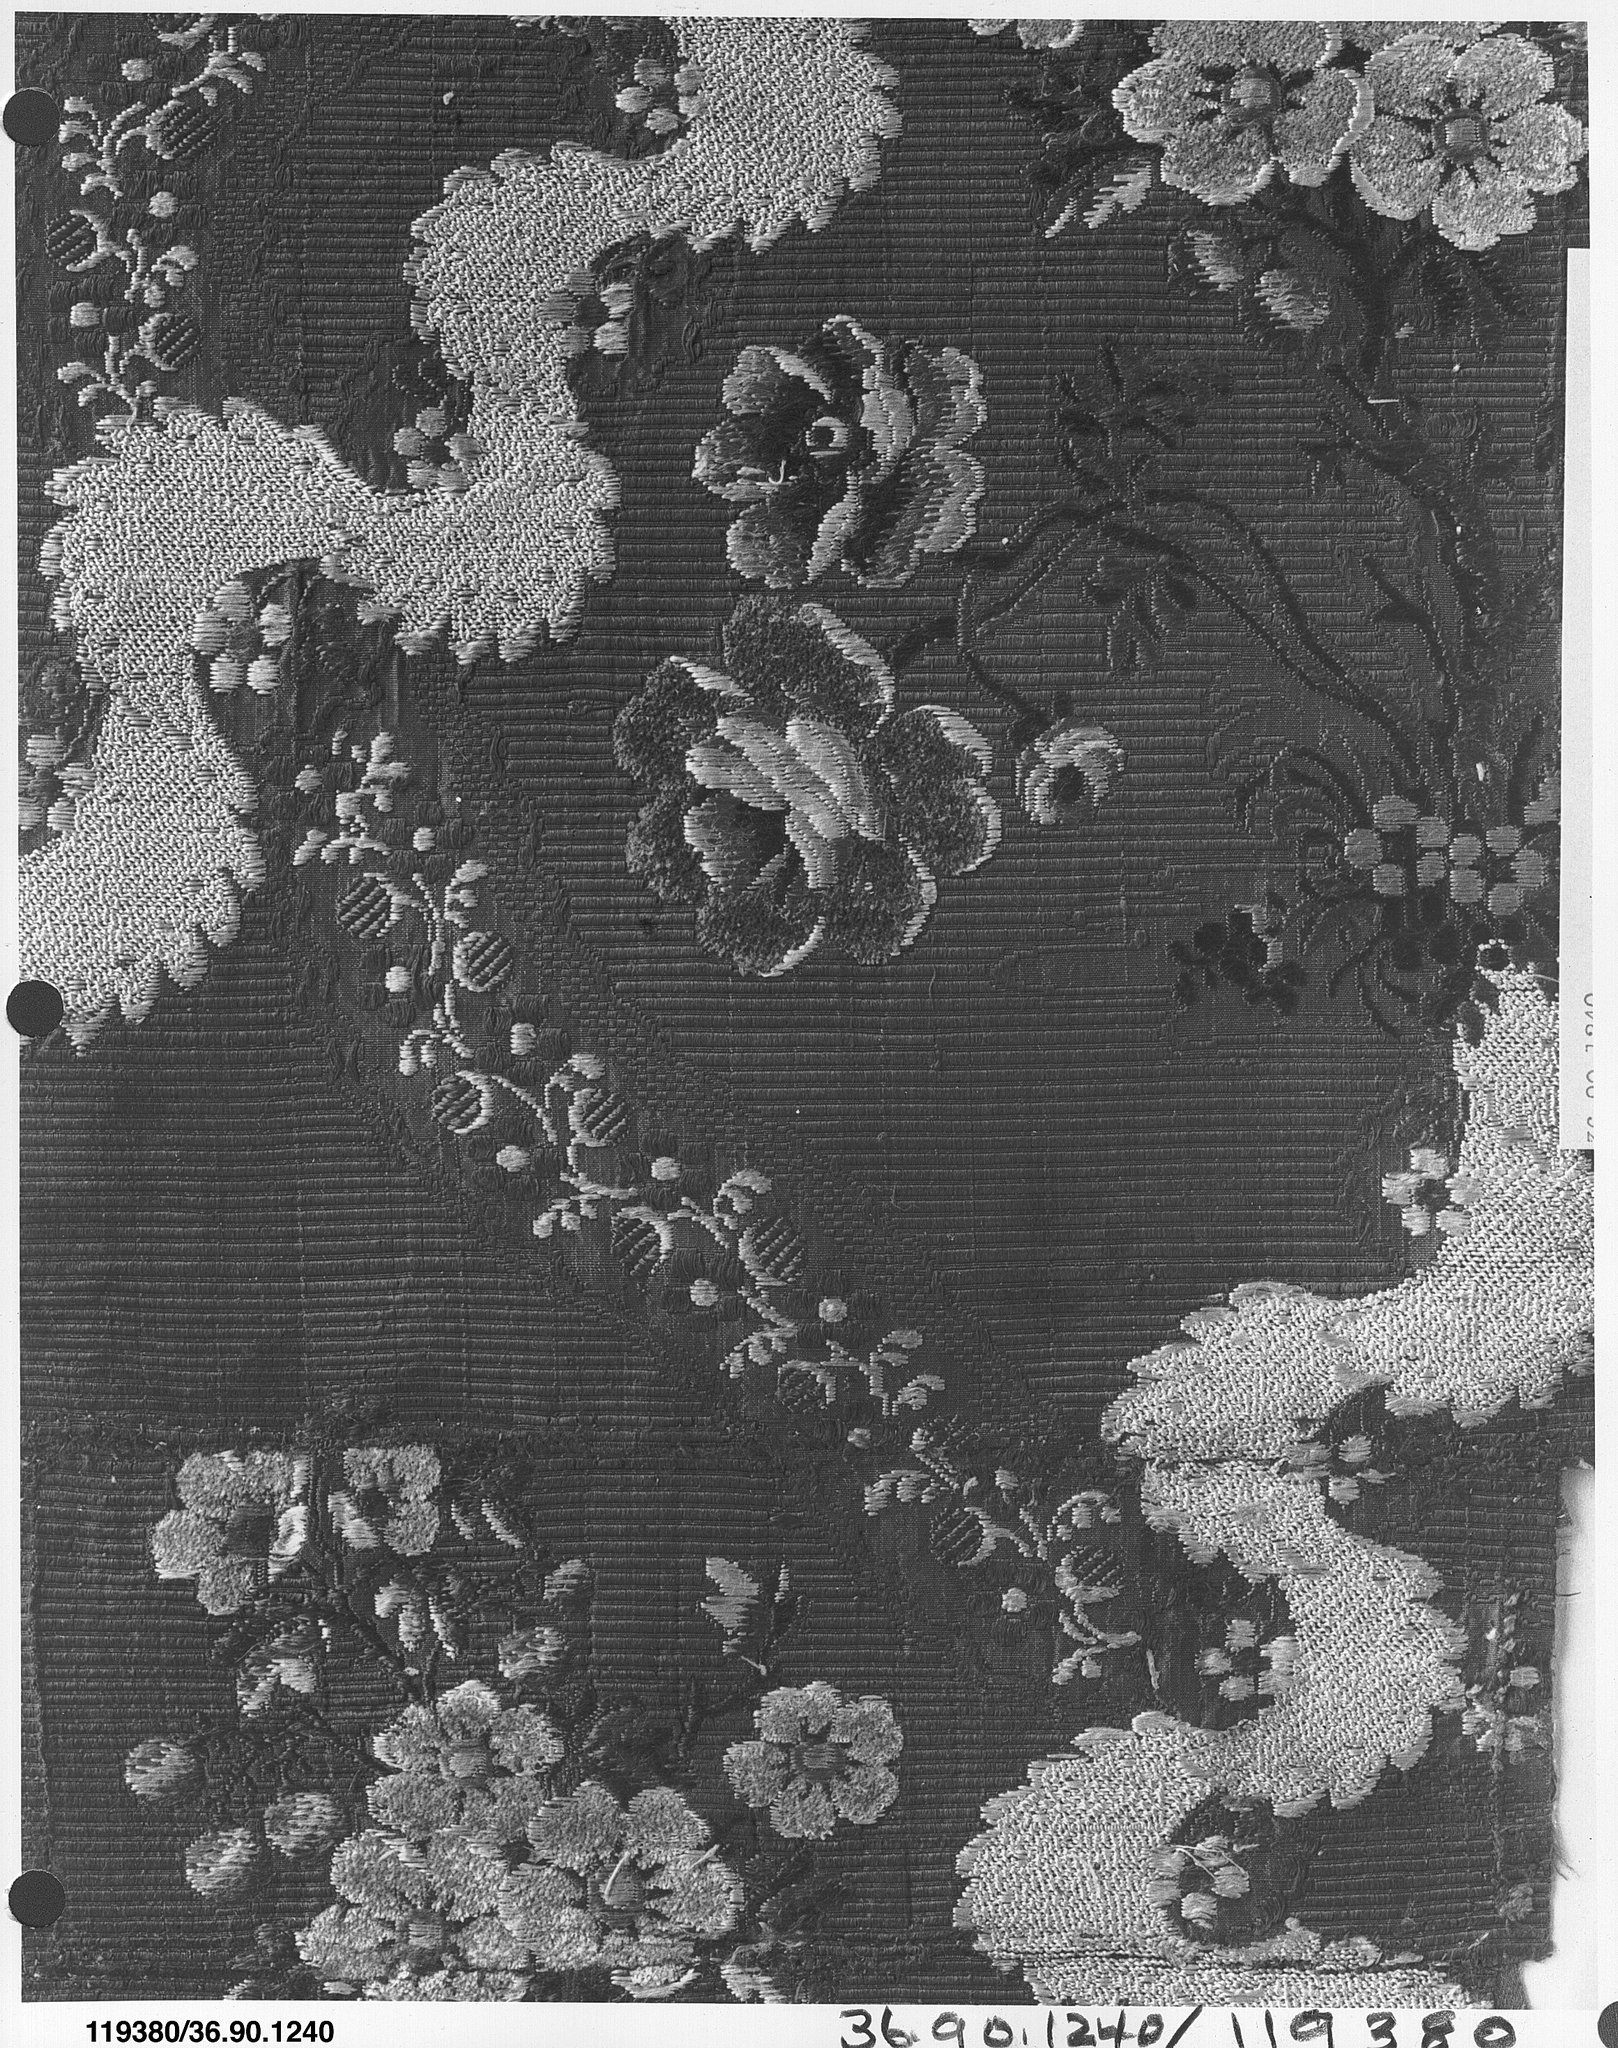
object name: piece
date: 1750-1760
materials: silk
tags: flowers